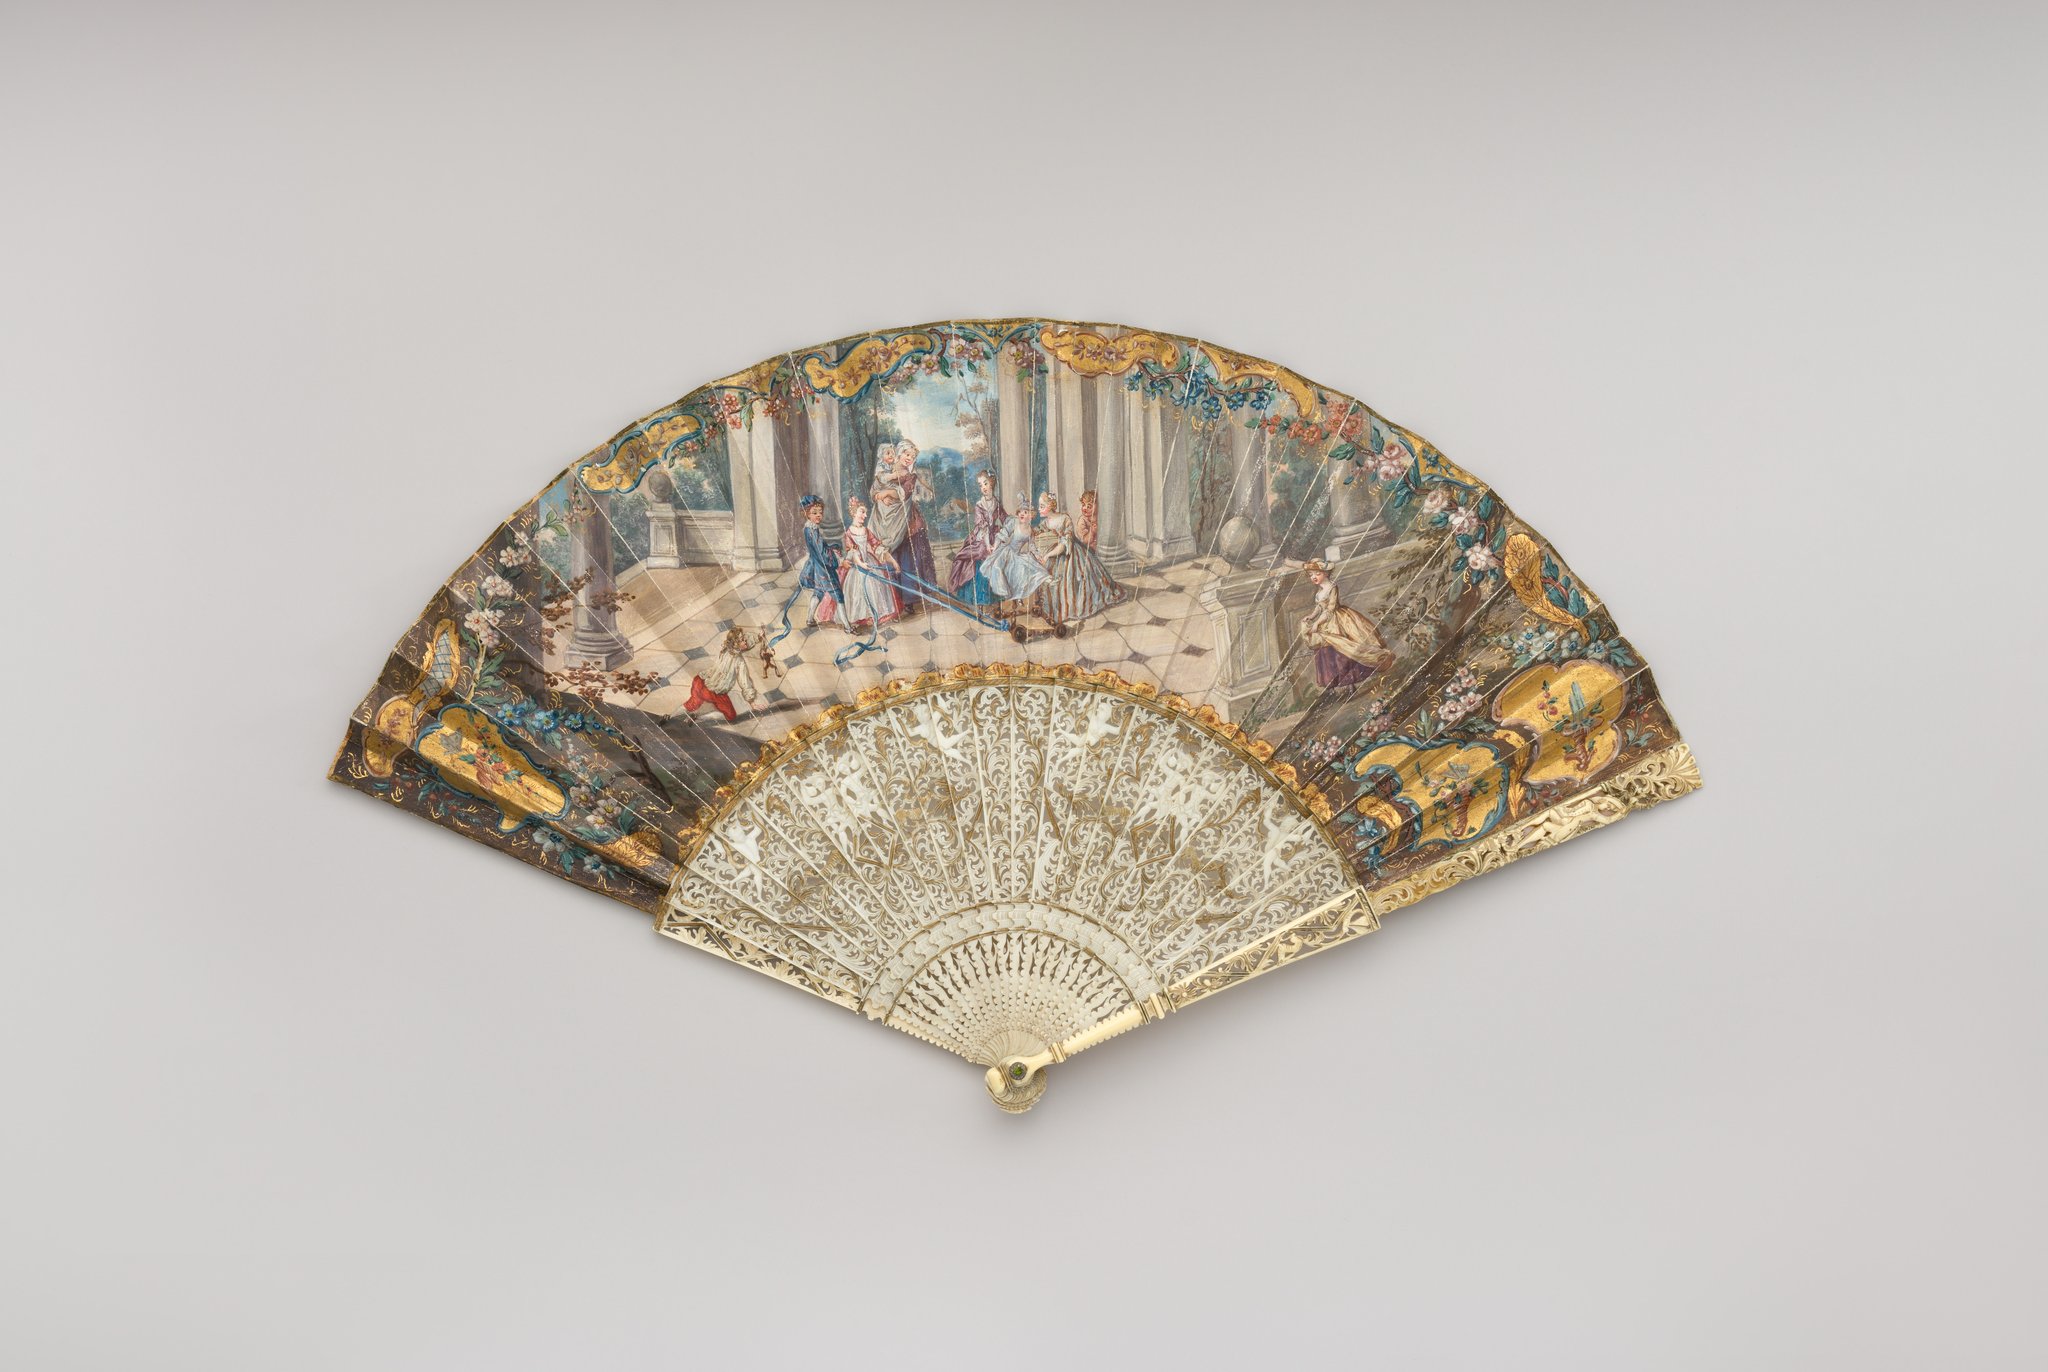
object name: fan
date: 1734-1766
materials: gilt, ivory, paint, paper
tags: children,women